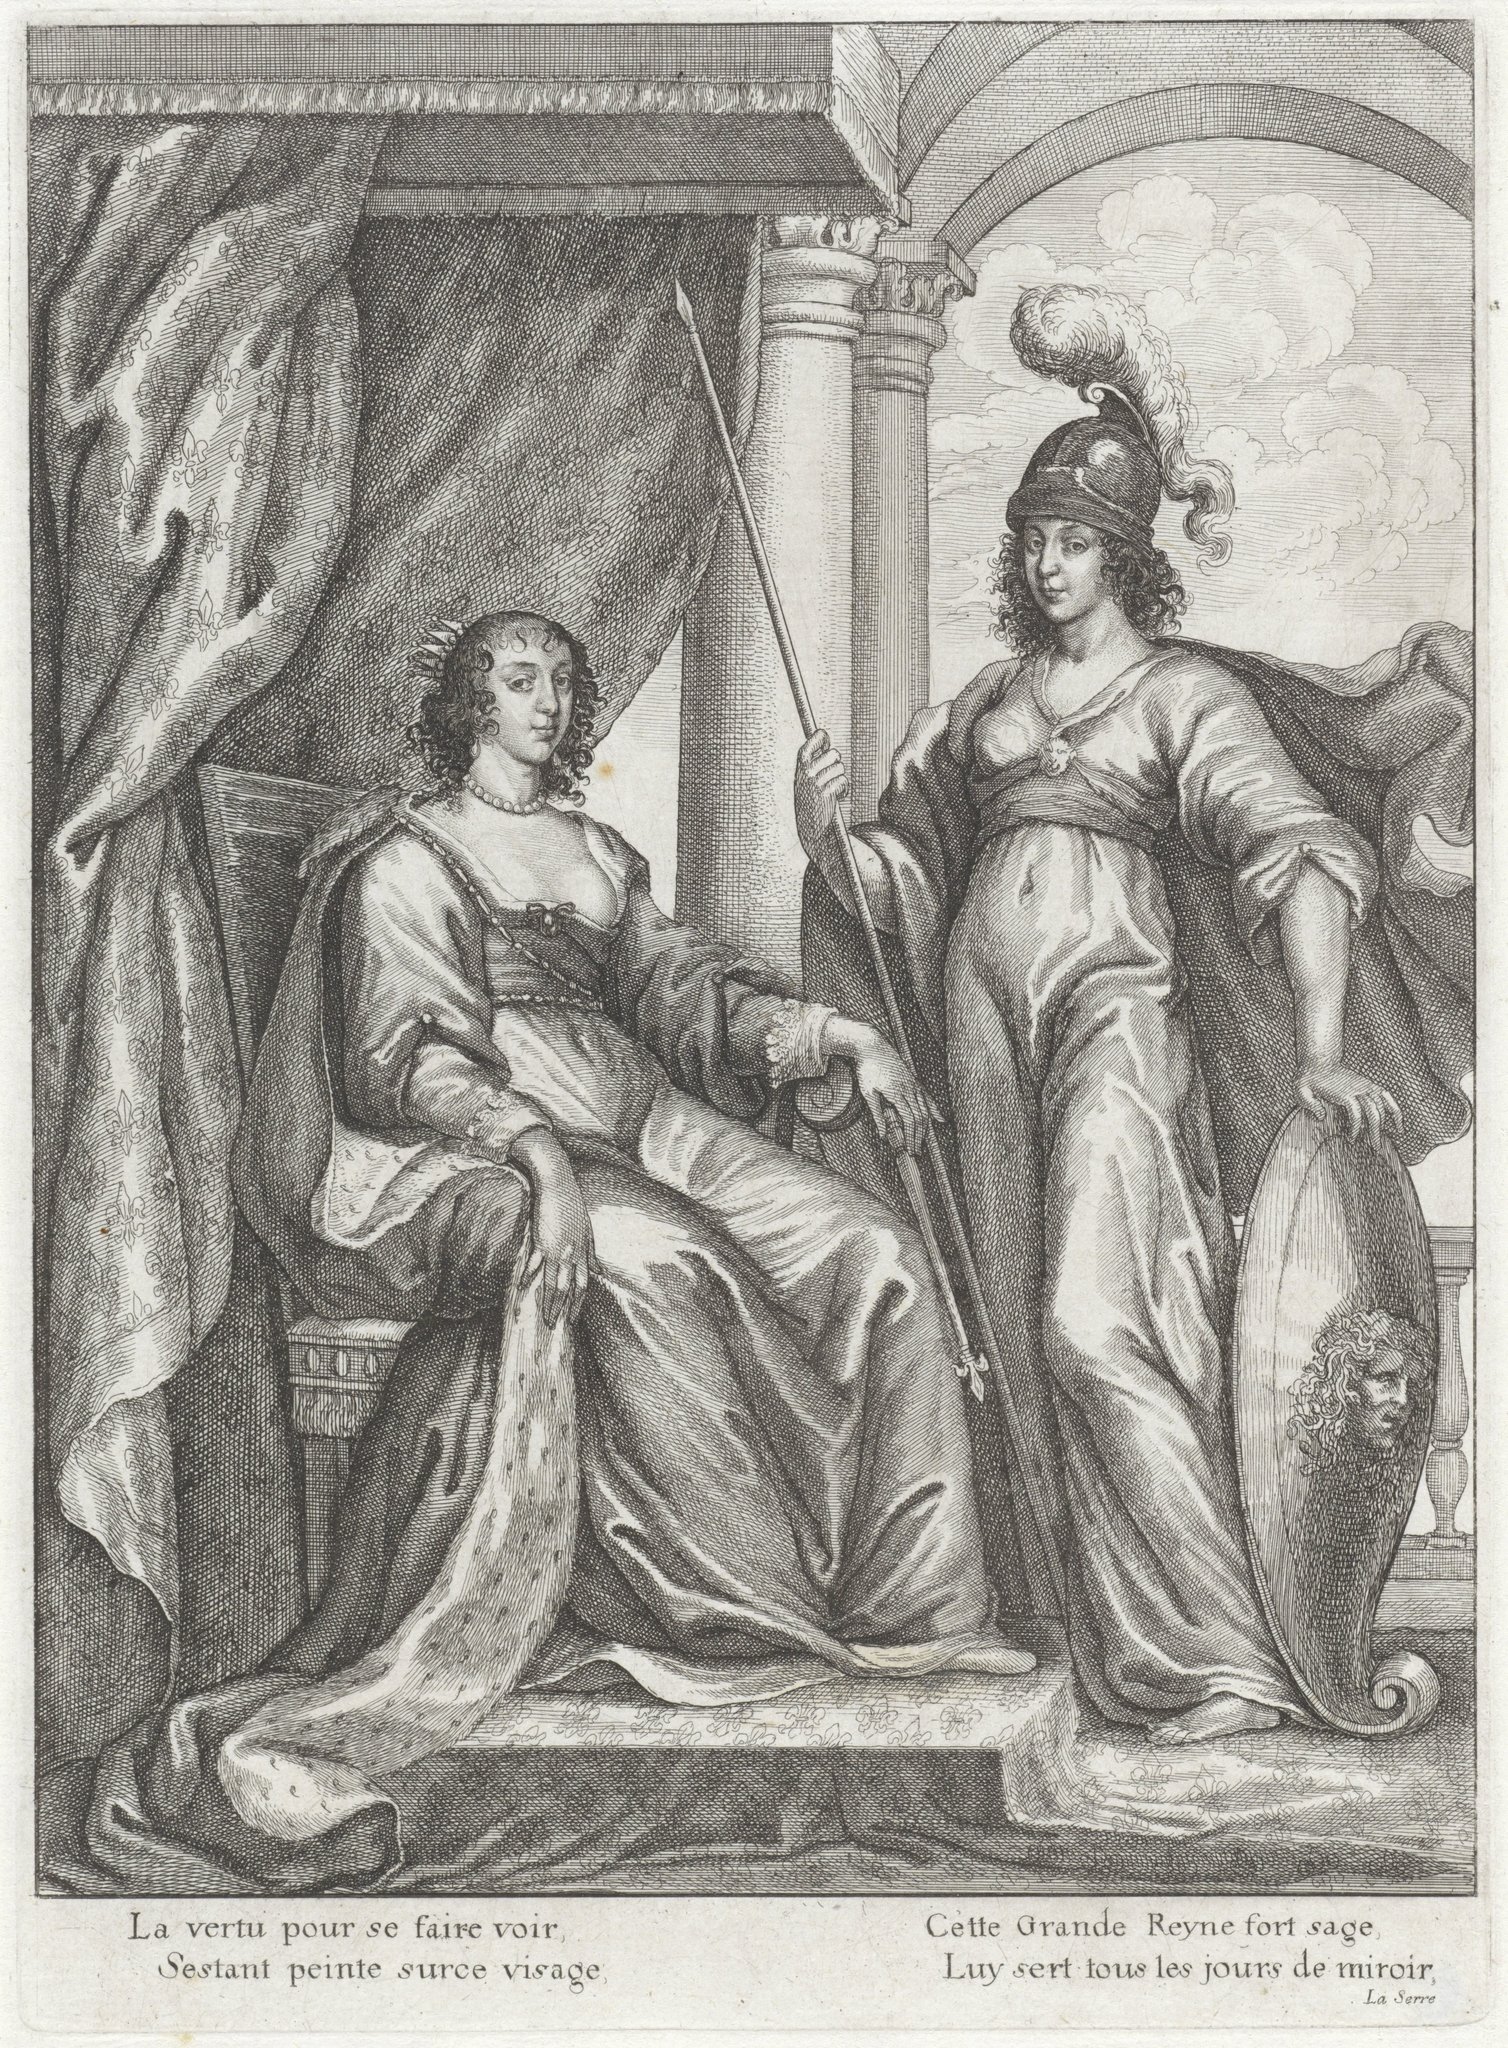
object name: book illustration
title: Tronende Henrietta Maria van Bourbon, koningin van Engeland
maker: wenceslaus hollar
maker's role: draughtsman, print maker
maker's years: 1607-1677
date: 1639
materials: paper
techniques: etching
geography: london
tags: henriëtta maria van frankrijk (koningin van engeland, schotland en ierland), (story of) minerva (pallas, athena), throne - bb - female ruler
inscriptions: collector's mark: Lugt 2228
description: Illustratie uit: La Serre, Jean Puget de. Histoire de l'entree de la Reine mere du Roy trés chrestien dans la Grande Bretaigne. Londen, 1639.